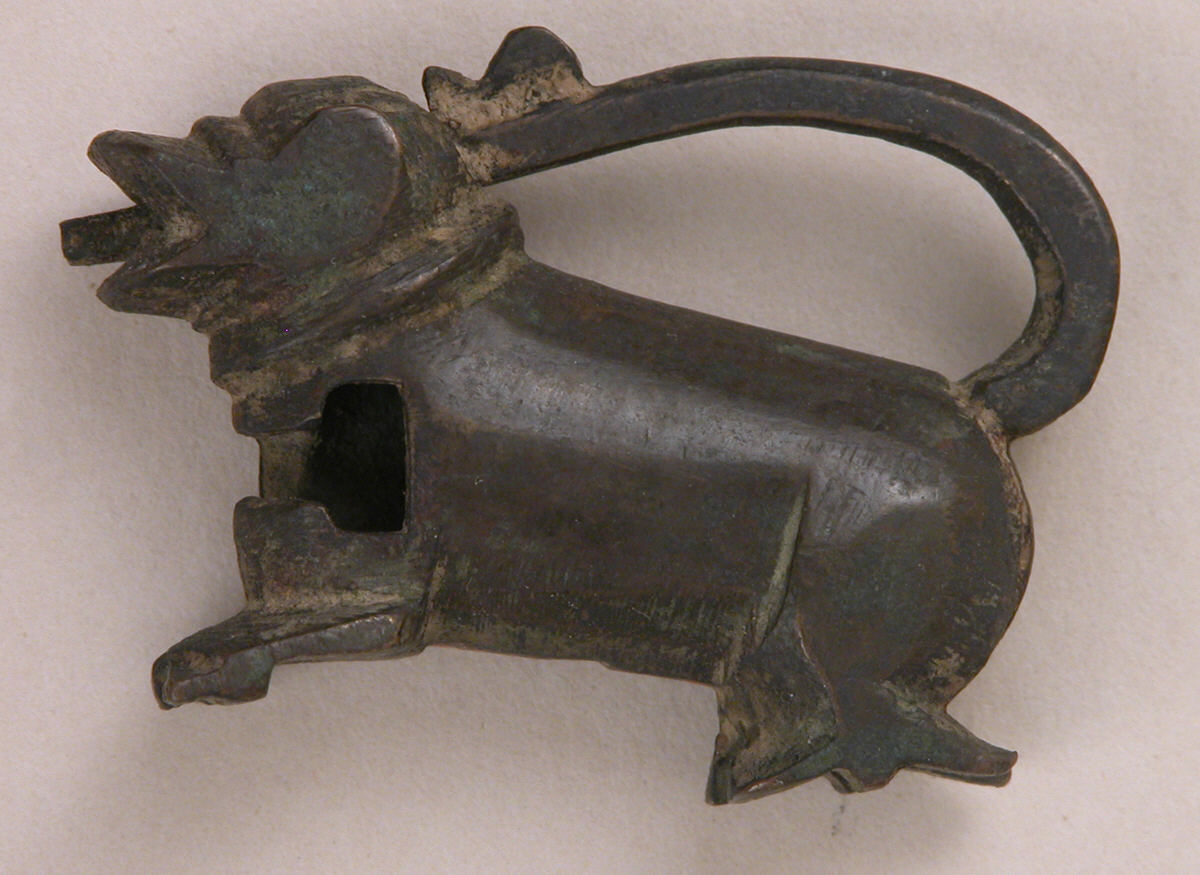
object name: padlock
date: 1001-1100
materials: bronze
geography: iraq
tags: animals